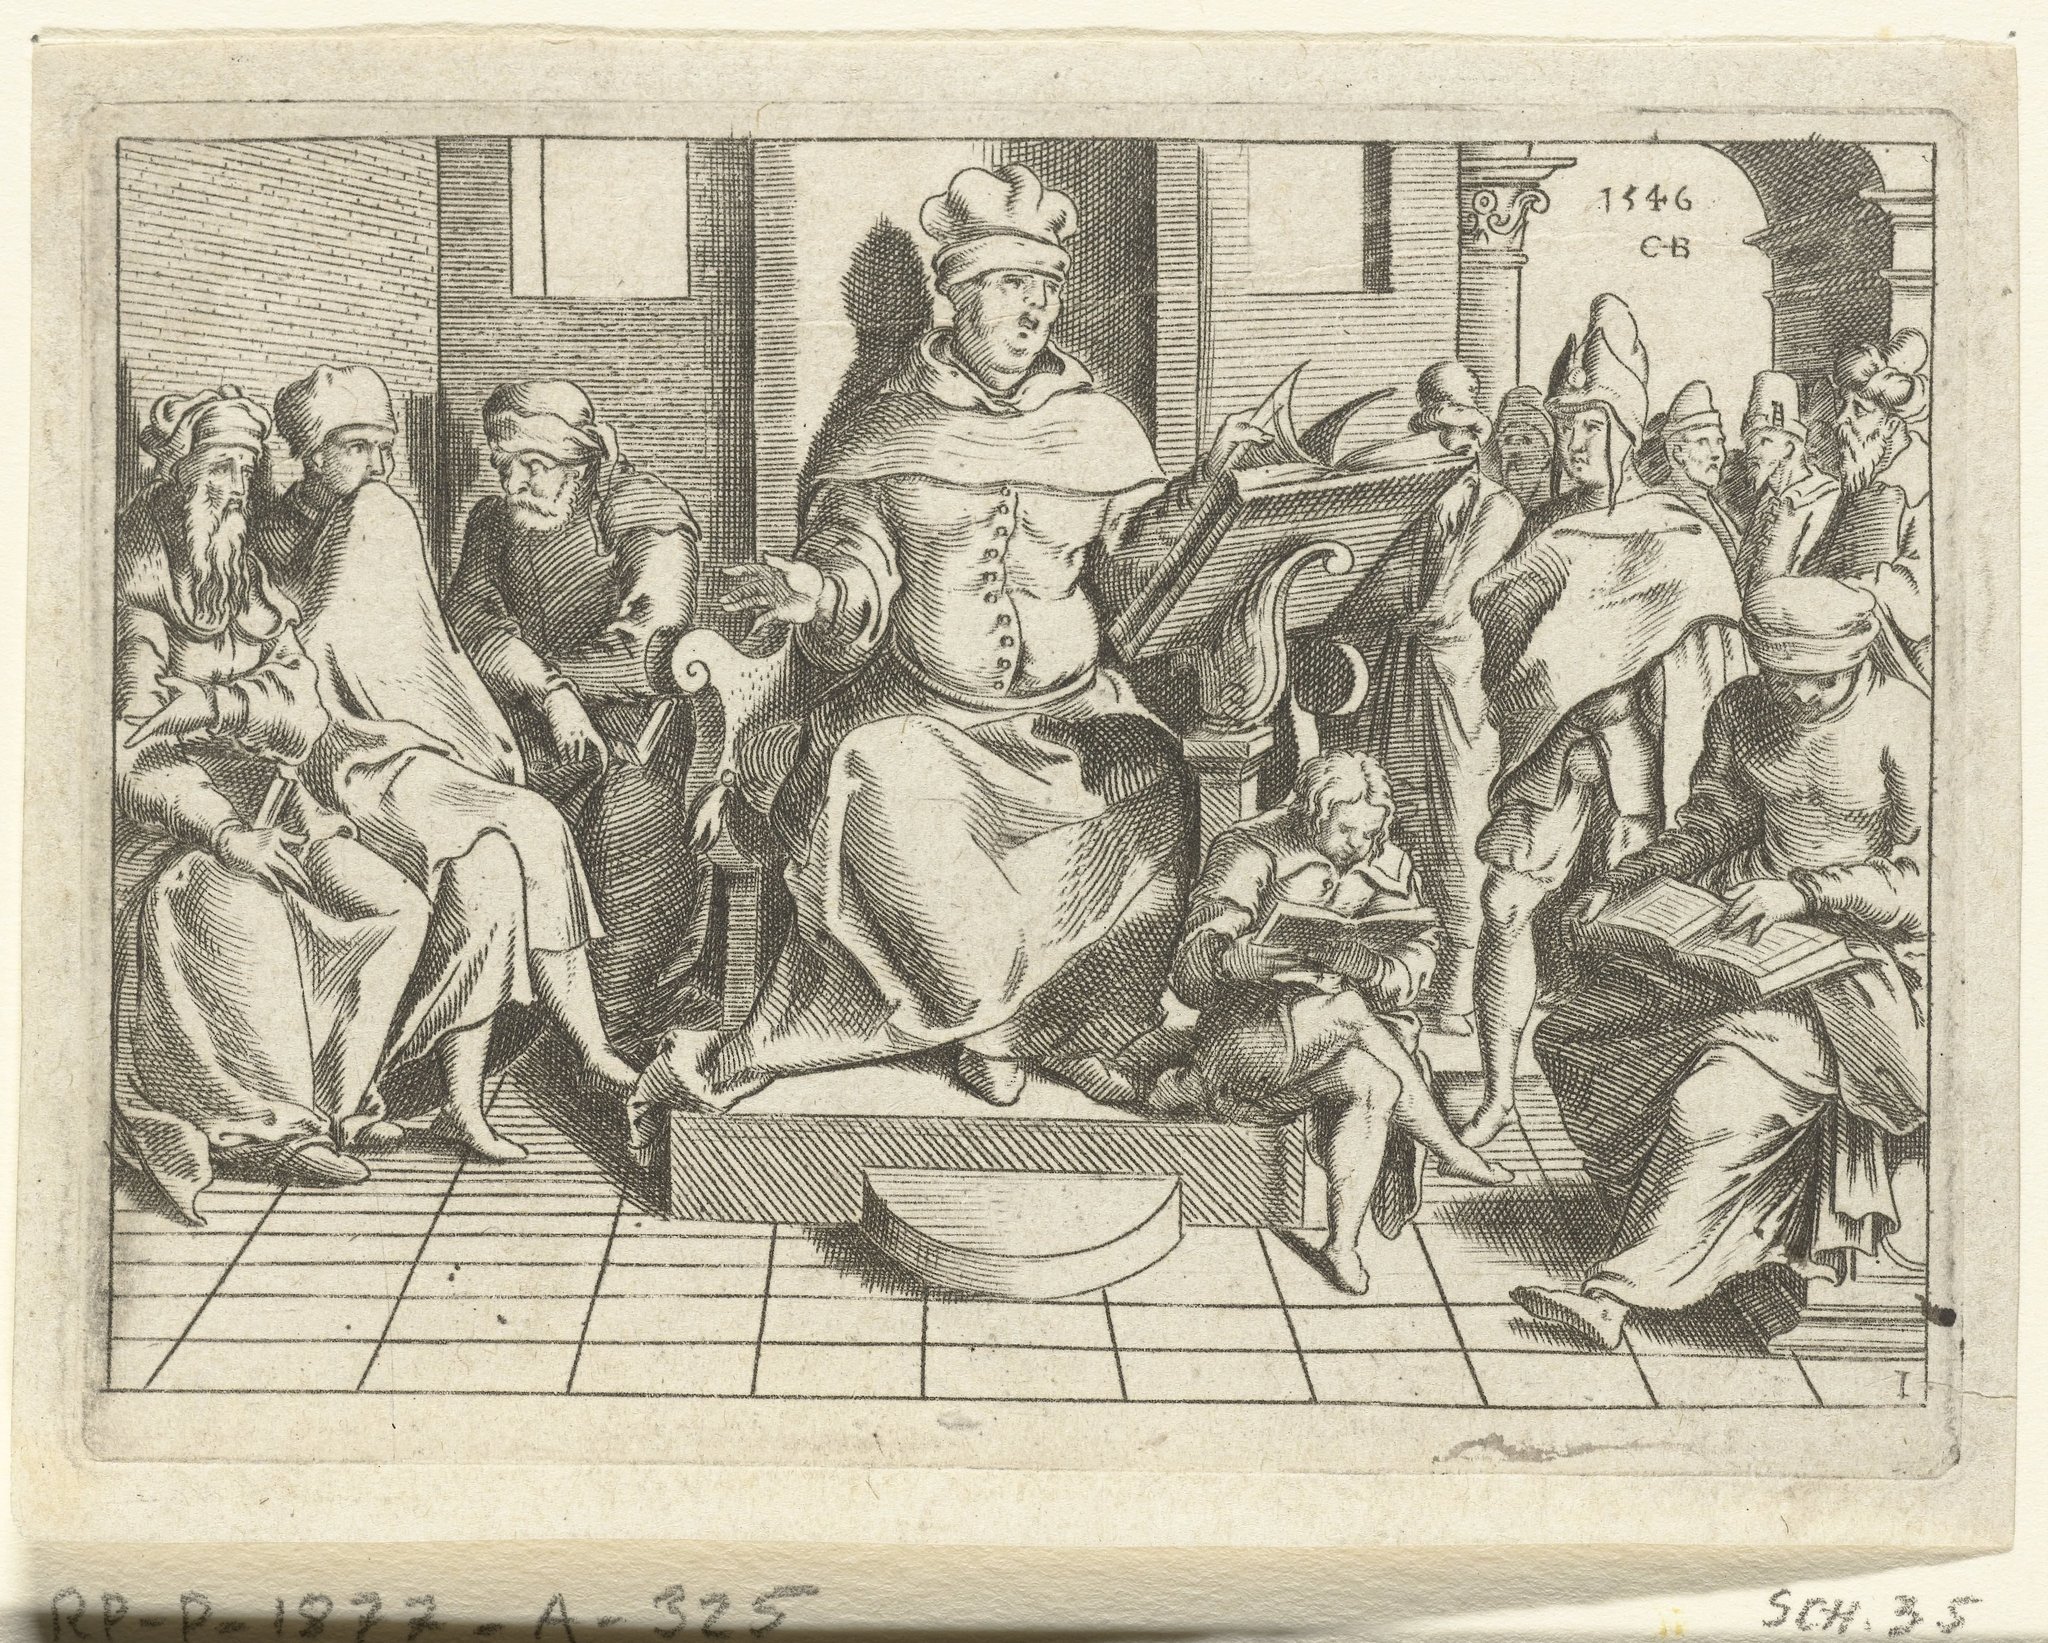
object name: print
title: Het leven van Paulus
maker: cornelis bos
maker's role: print maker, printer, publisher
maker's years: 1510-1566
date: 1546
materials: paper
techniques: engraving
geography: nuremberg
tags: life and acts of paul (saul)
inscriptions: collector's mark: Lugt 2228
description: Paulus zit als jonge leerling aan de voeten van de bekende wetsleraar Gamaliël. Prent uit een serie van 10 prenten met scènes uit het leven van de apostel Paulus.